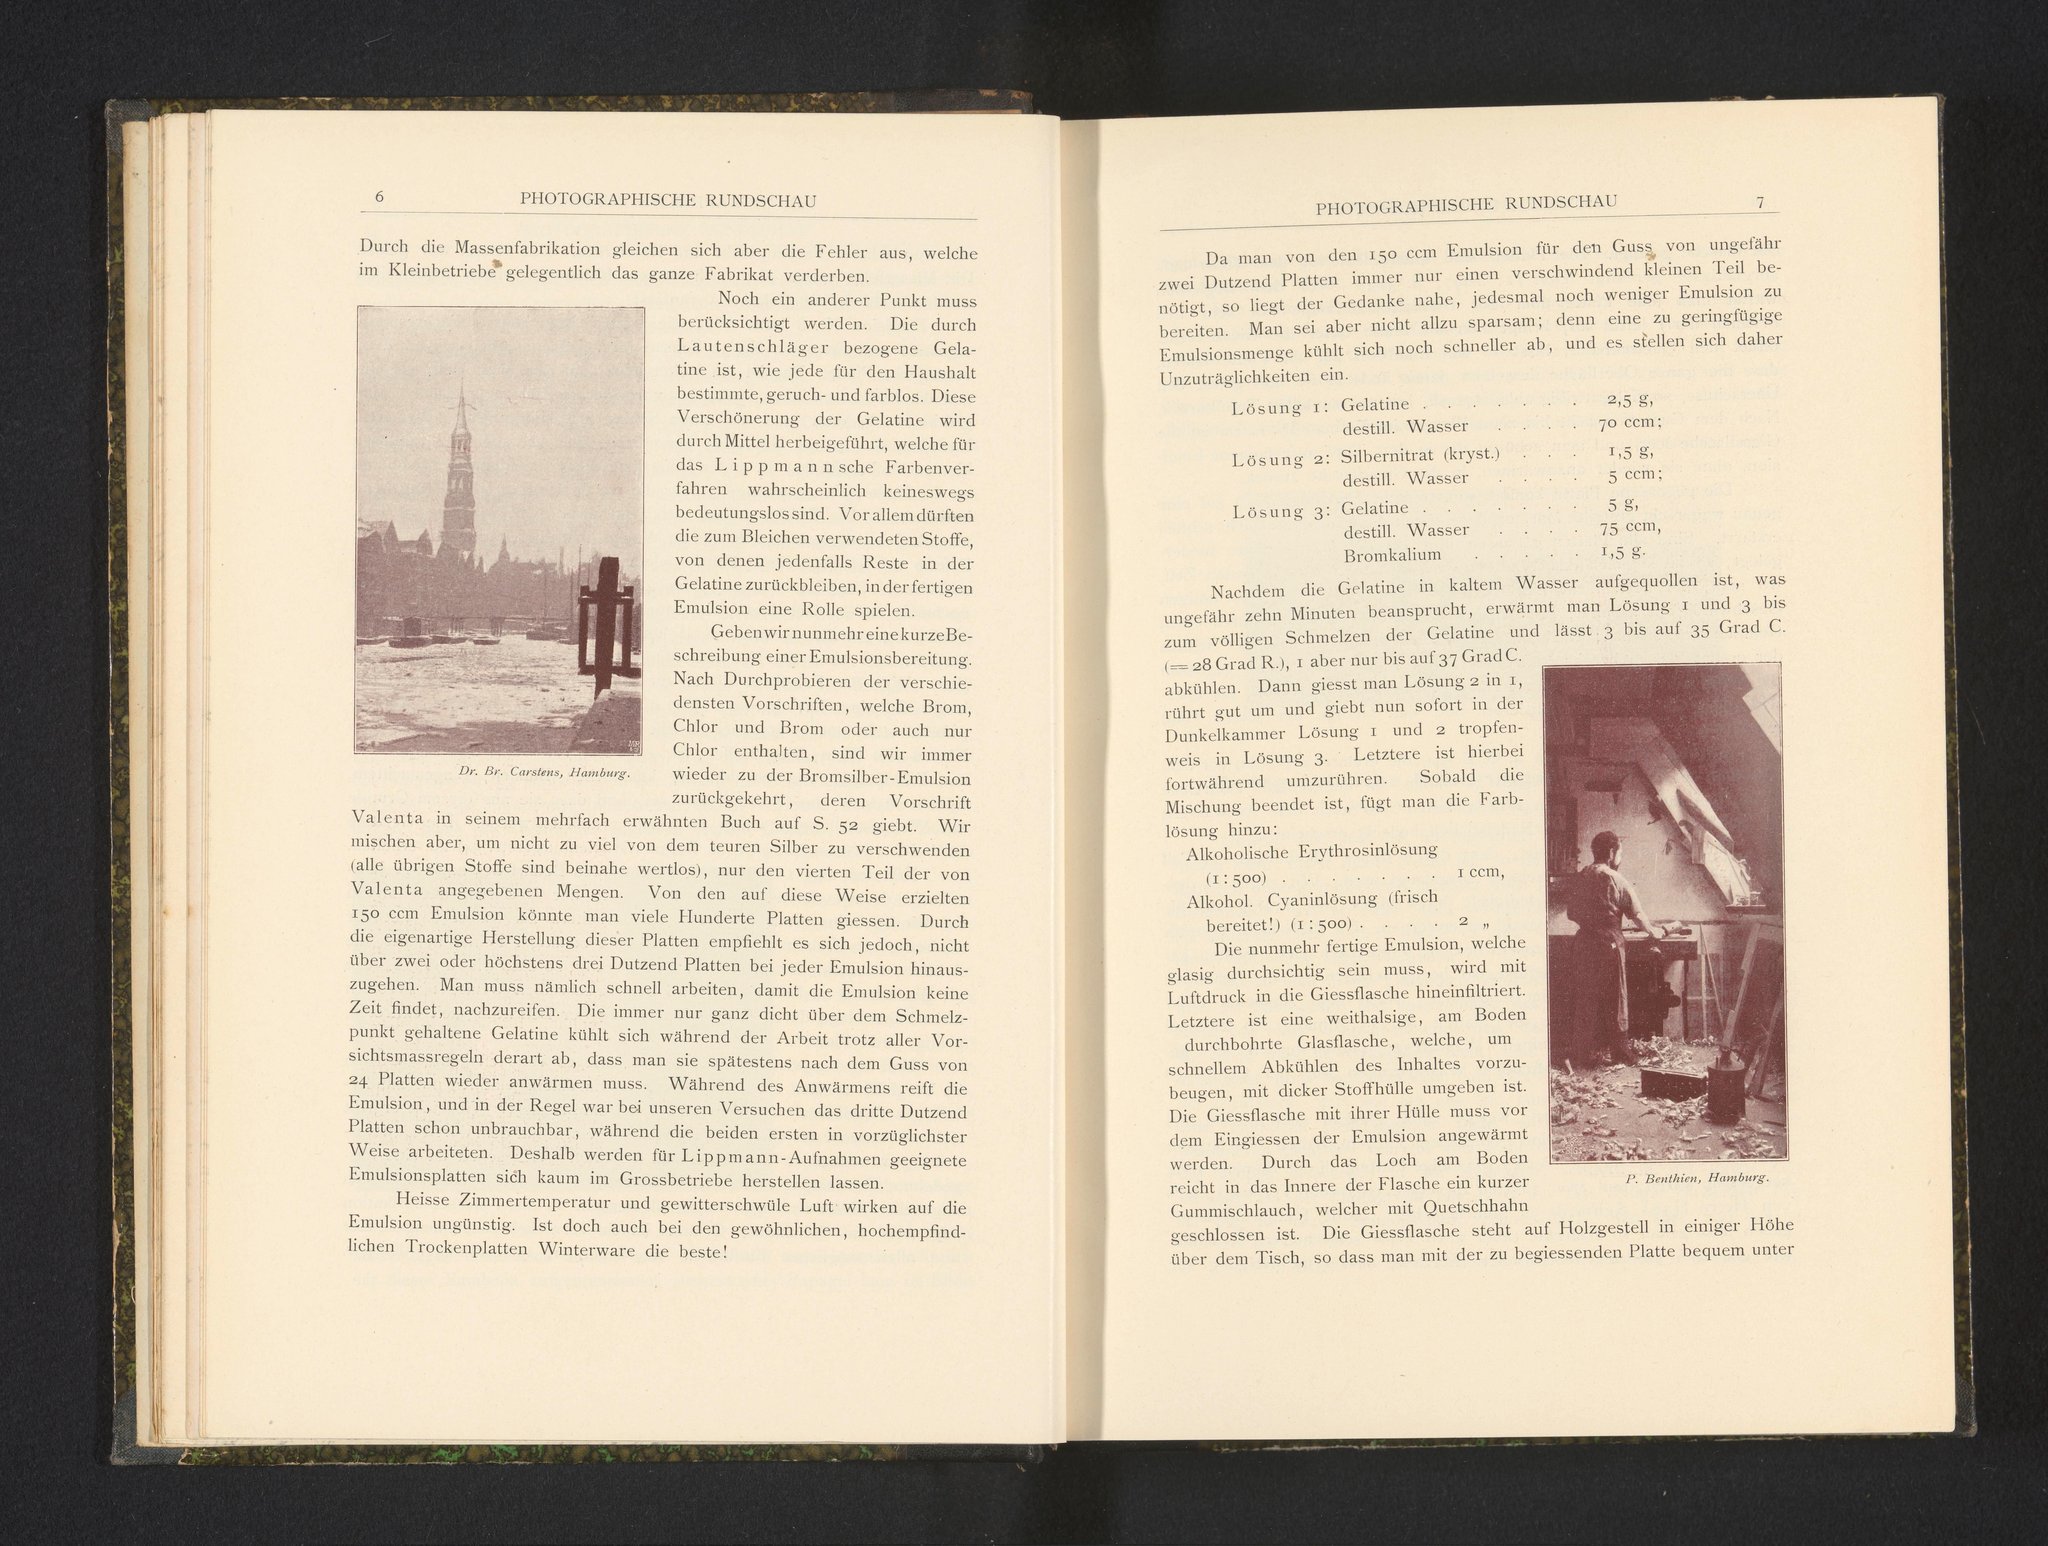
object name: page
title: Man in een atelier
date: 1893-1898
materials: paper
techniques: autotype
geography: hamburg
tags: artist at work, in his workshop